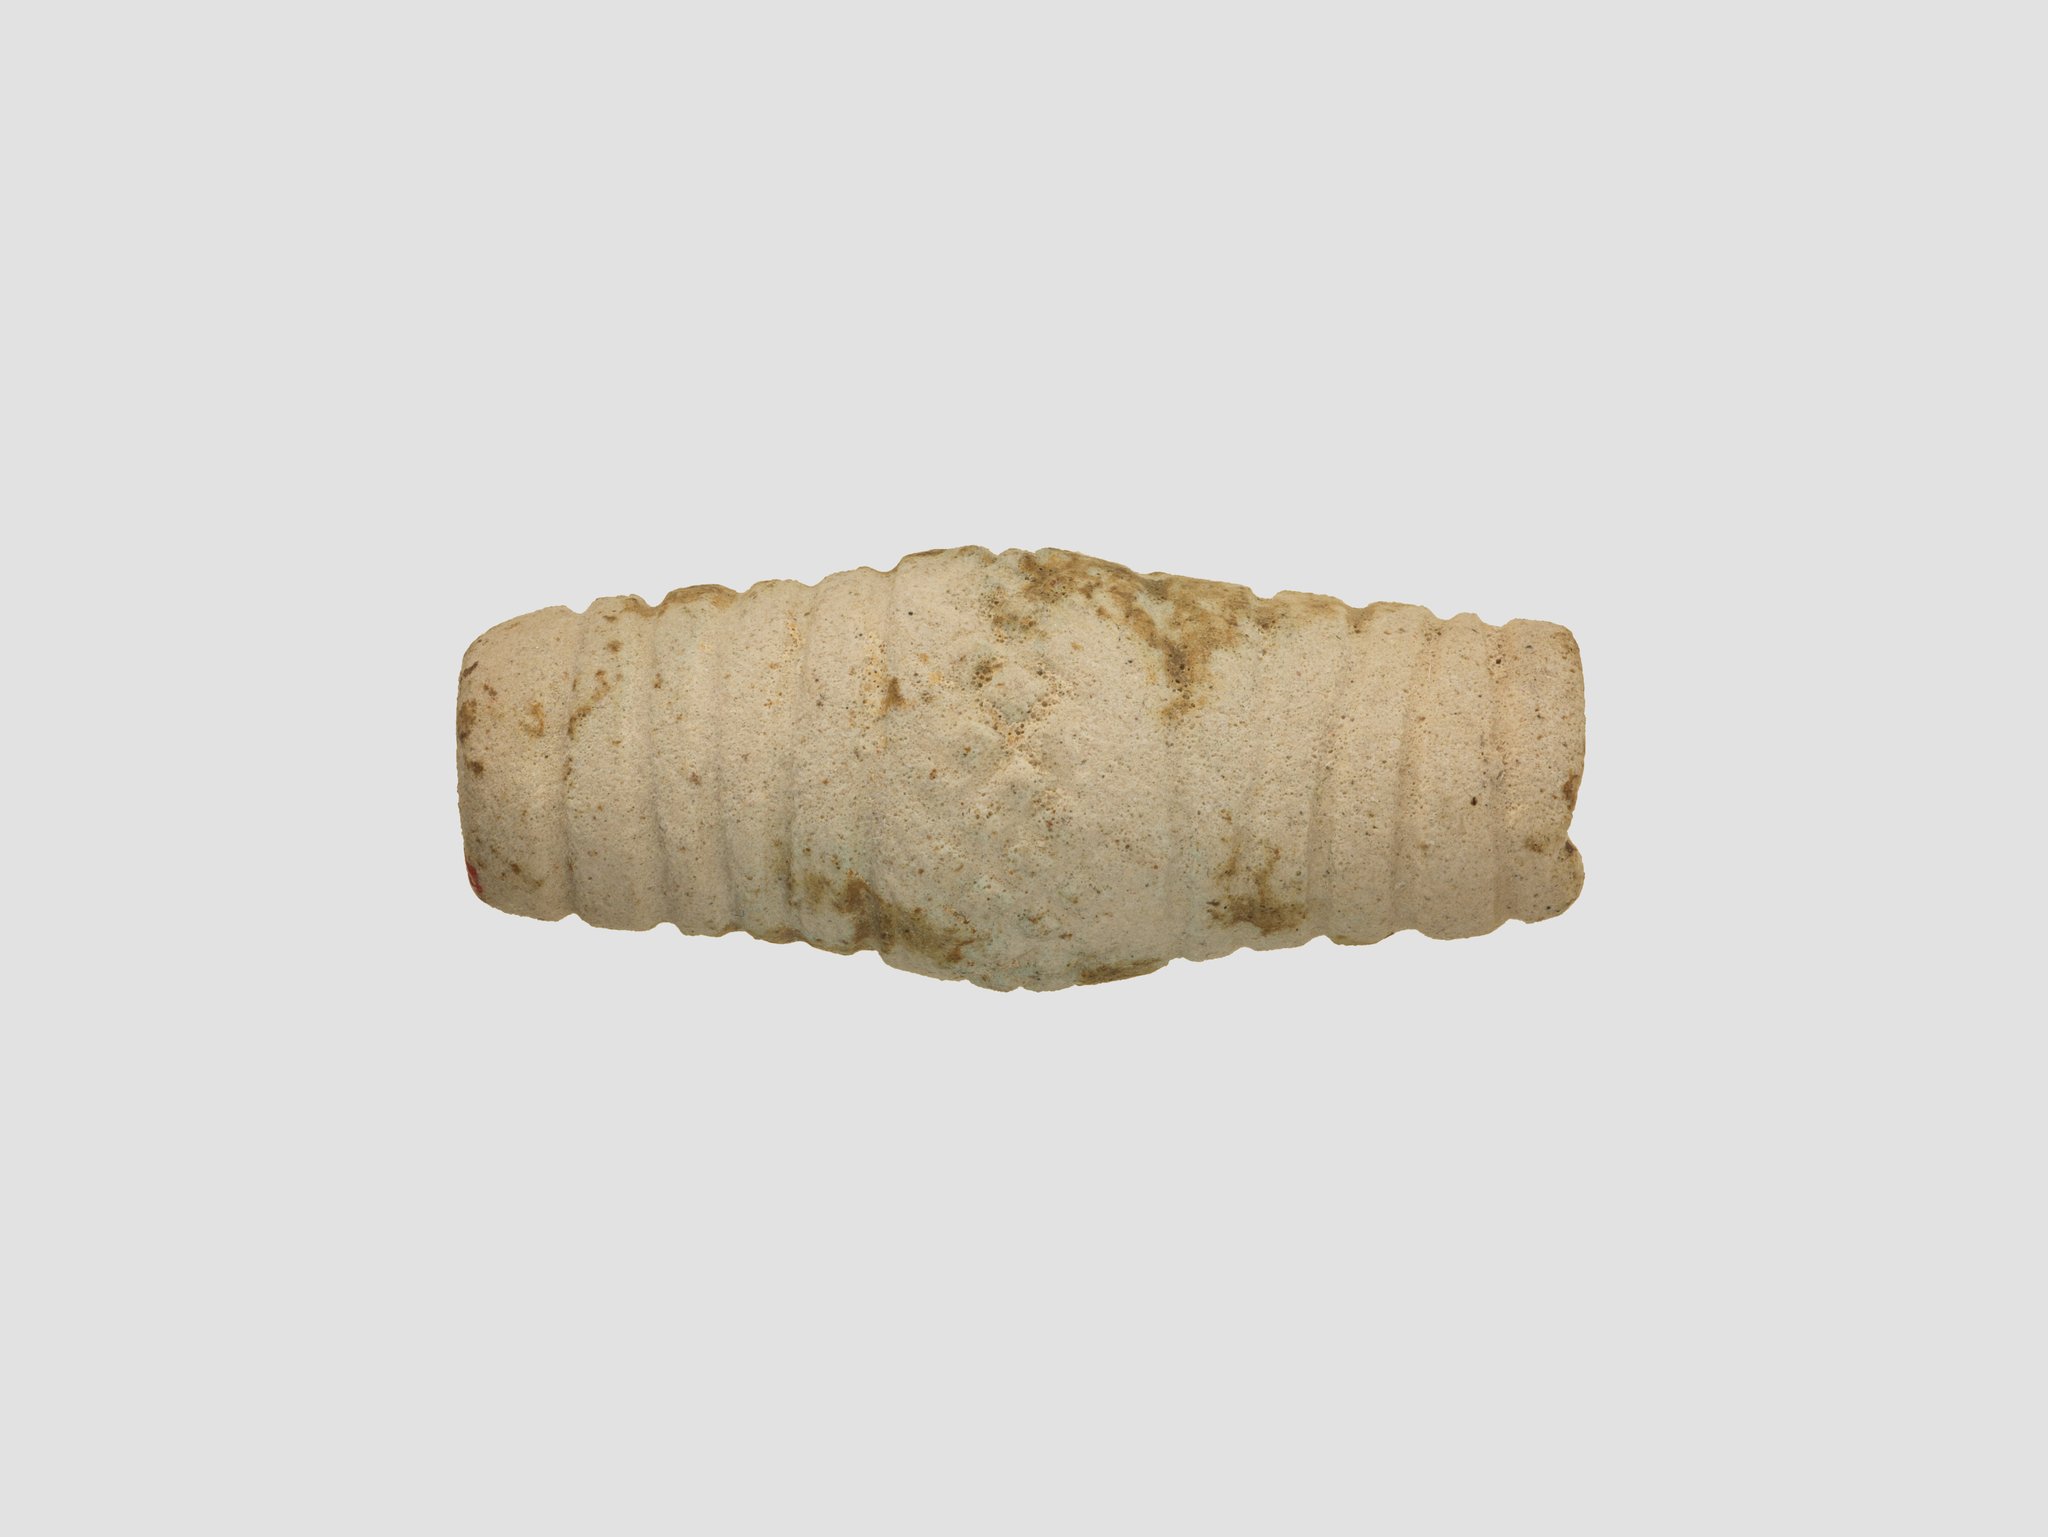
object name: bead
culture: iranian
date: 900-801 BCE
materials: faience, glaze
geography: iran